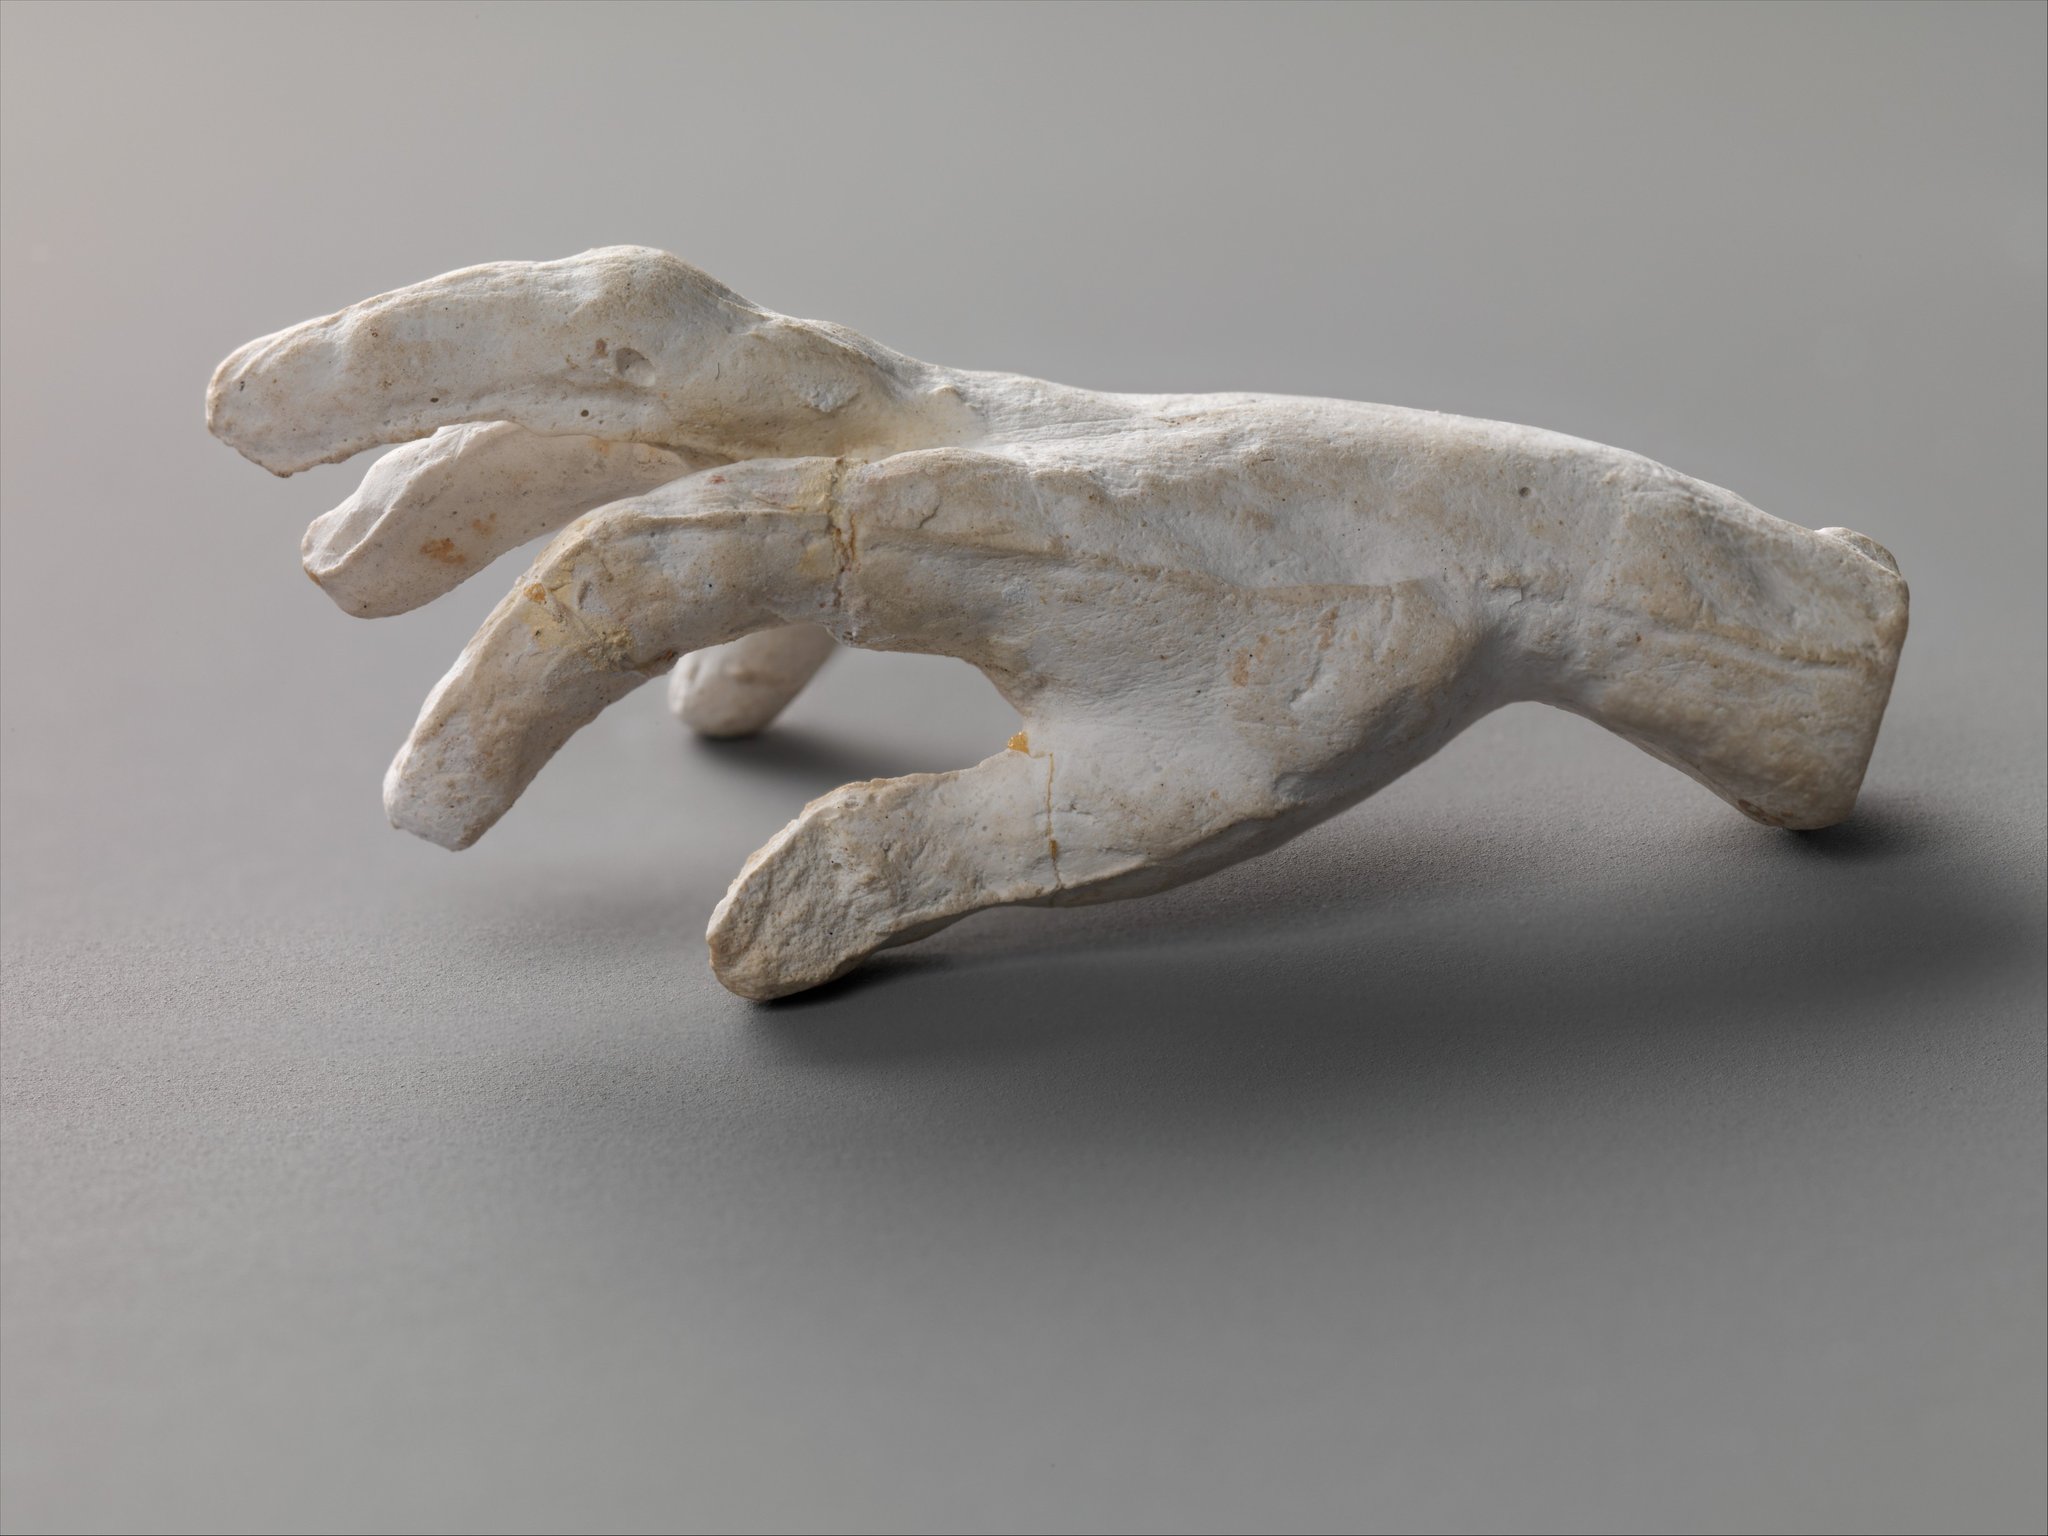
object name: cast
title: Study of a hand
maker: auguste rodin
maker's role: artist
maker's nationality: french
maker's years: 1840-1917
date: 1901-2000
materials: plaster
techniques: casting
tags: hands